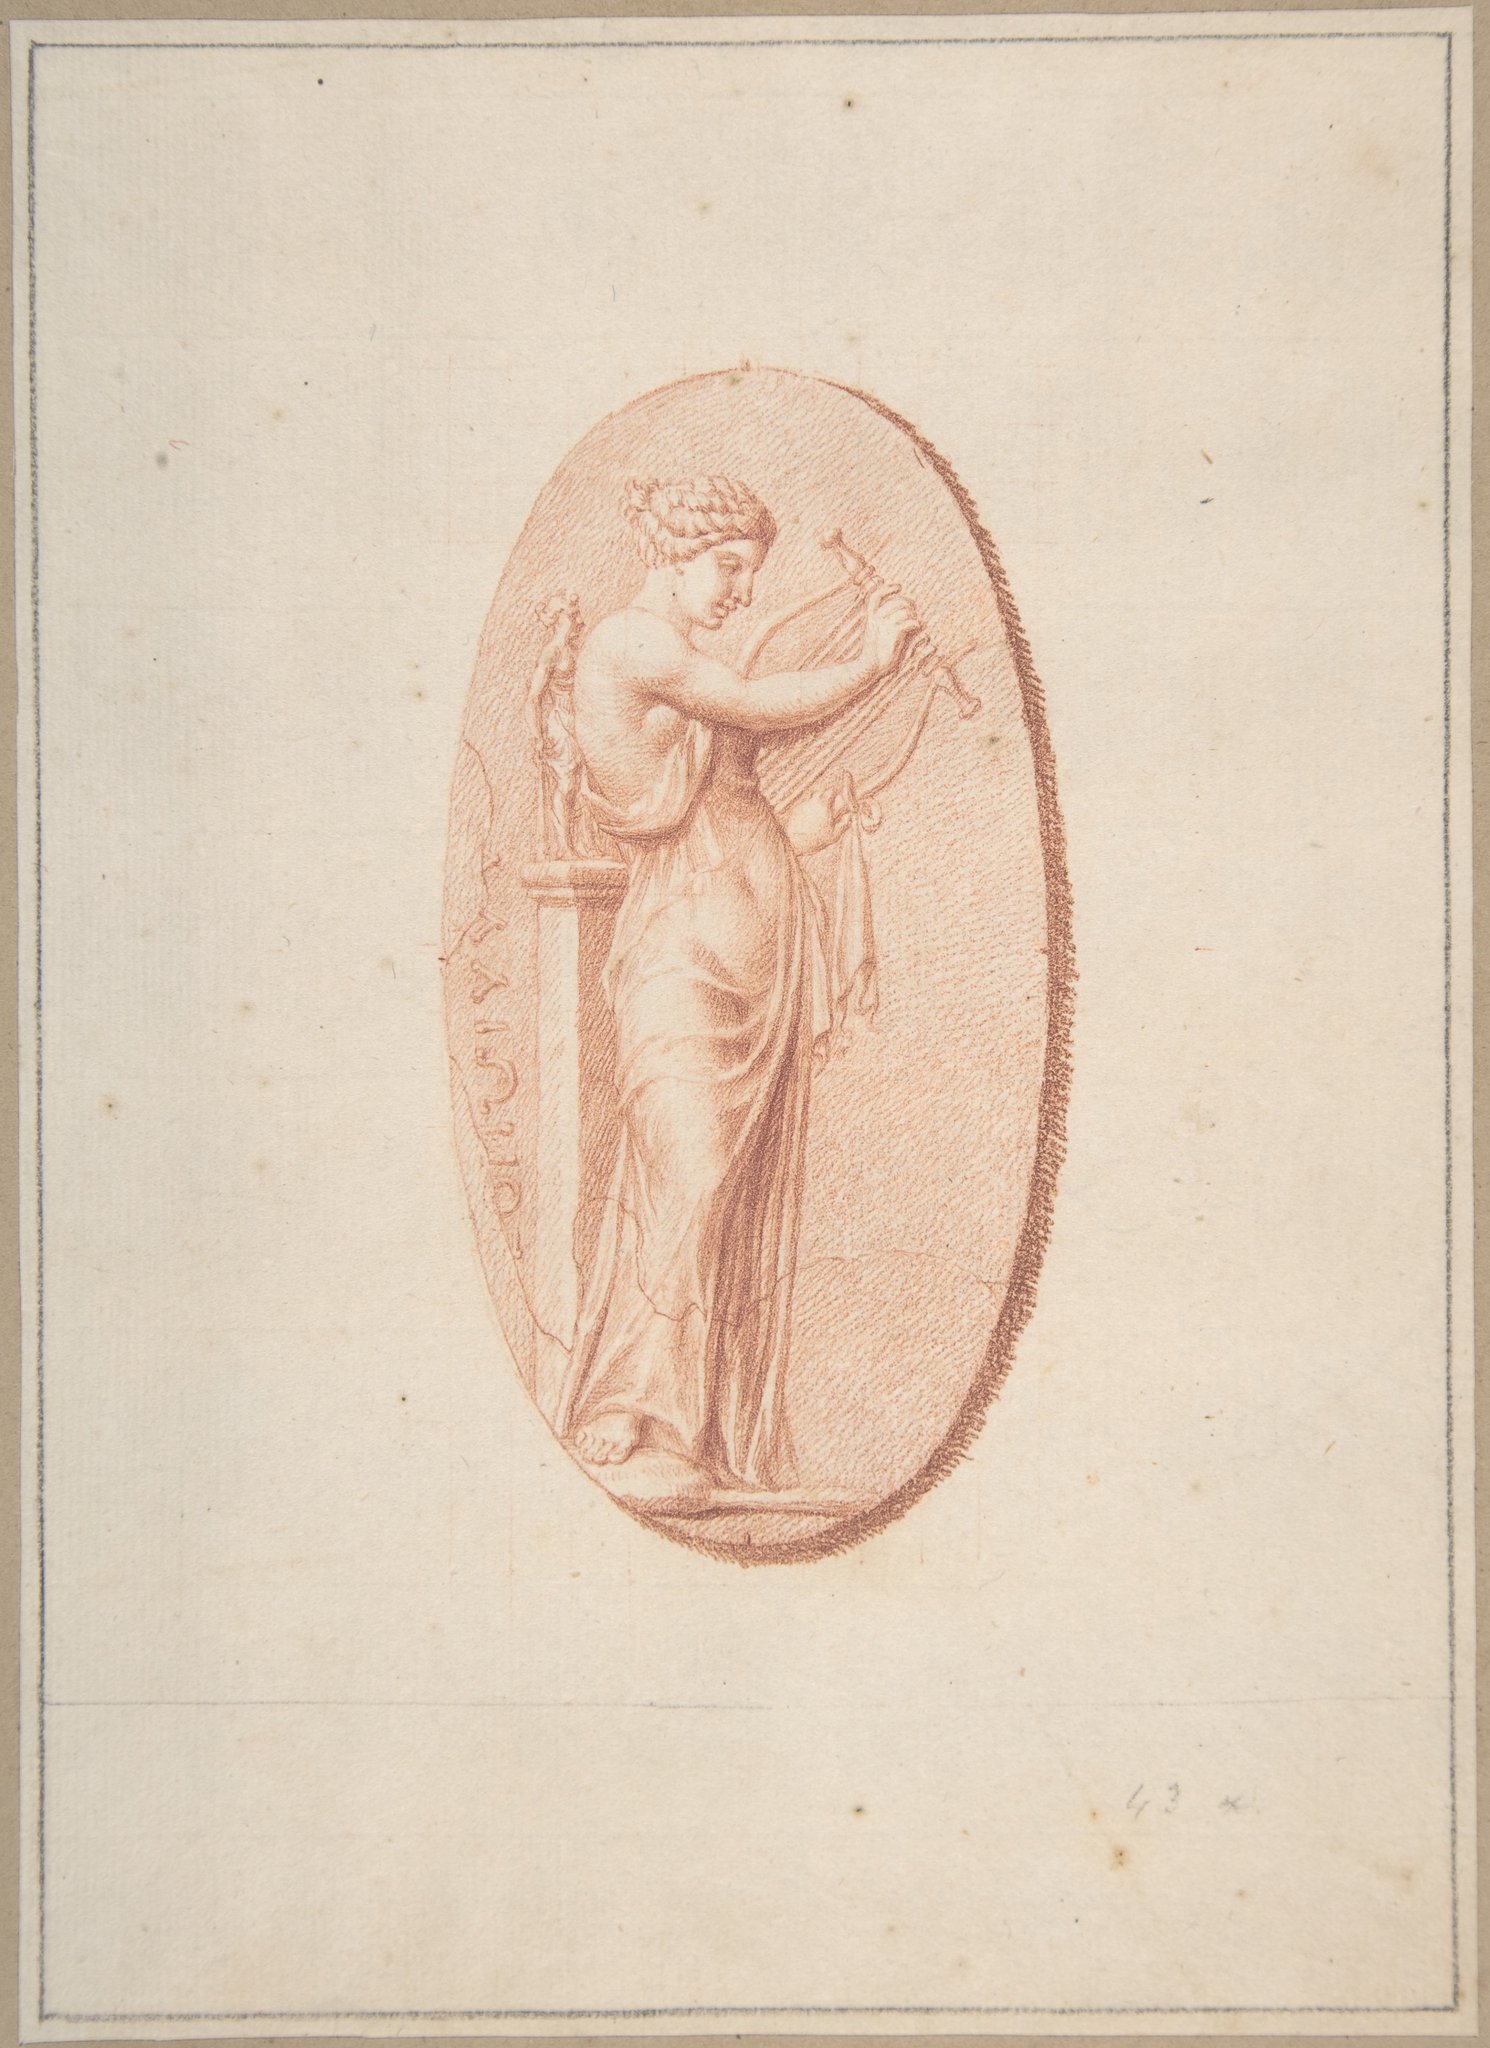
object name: drawing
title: A Muse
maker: bernard picart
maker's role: artist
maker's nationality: french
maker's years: 1673-1733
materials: chalk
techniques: drawing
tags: musical instruments,women,muses